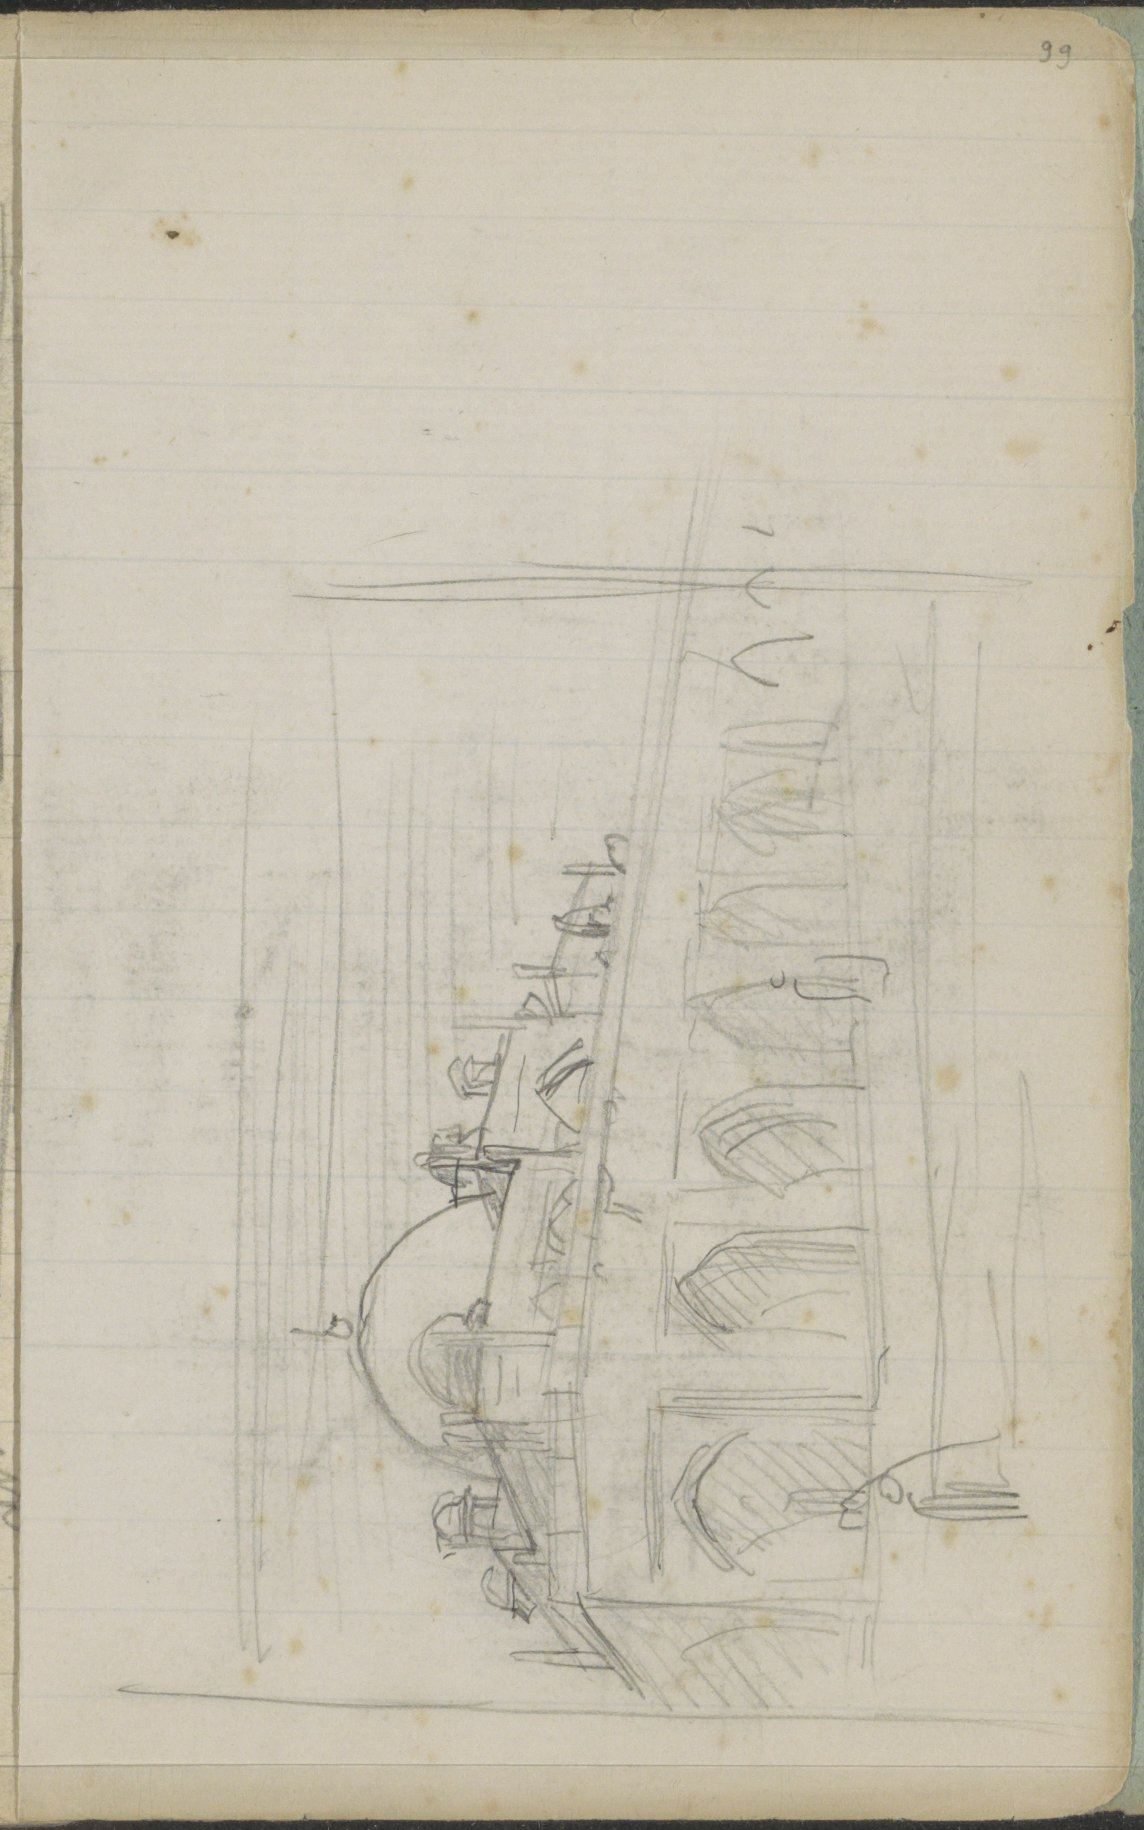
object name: sketchbook leaf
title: Gebouw met een koepeldak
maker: marius bauer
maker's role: draughtsman, print maker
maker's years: 1867-1932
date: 1902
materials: pencil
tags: church (exterior), dome ~ architecture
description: Vermoedelijk een kerk. Pagina 99 uit een schetsboek met 50 bladen.